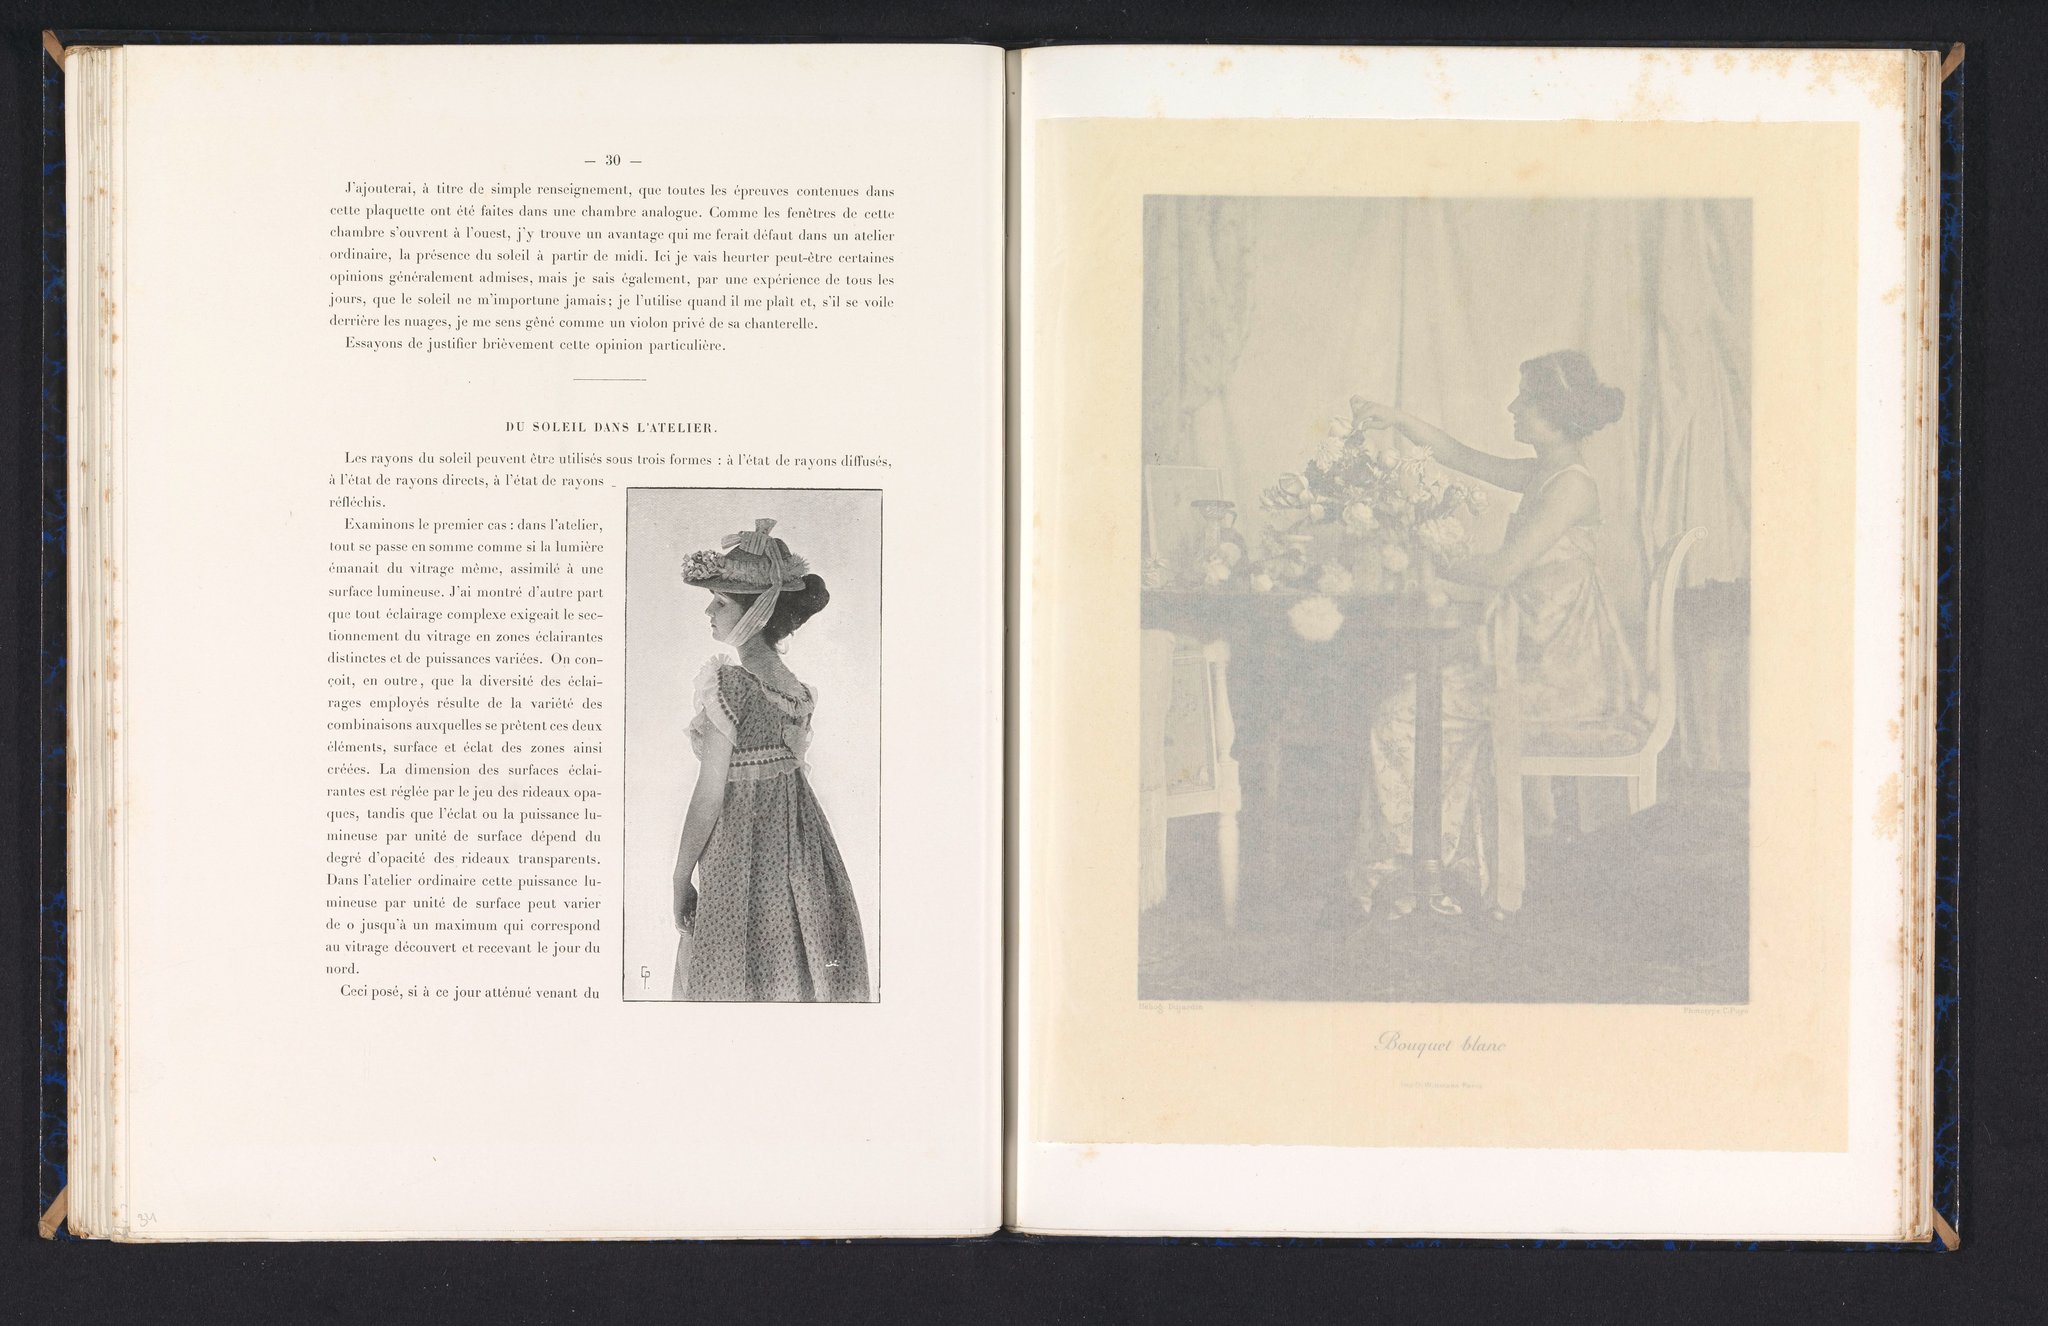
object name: photomechanical print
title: Portret van een onbekende vrouw met een hoed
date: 1886-1896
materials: paper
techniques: autotype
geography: france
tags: adult woman, head-gear: hat